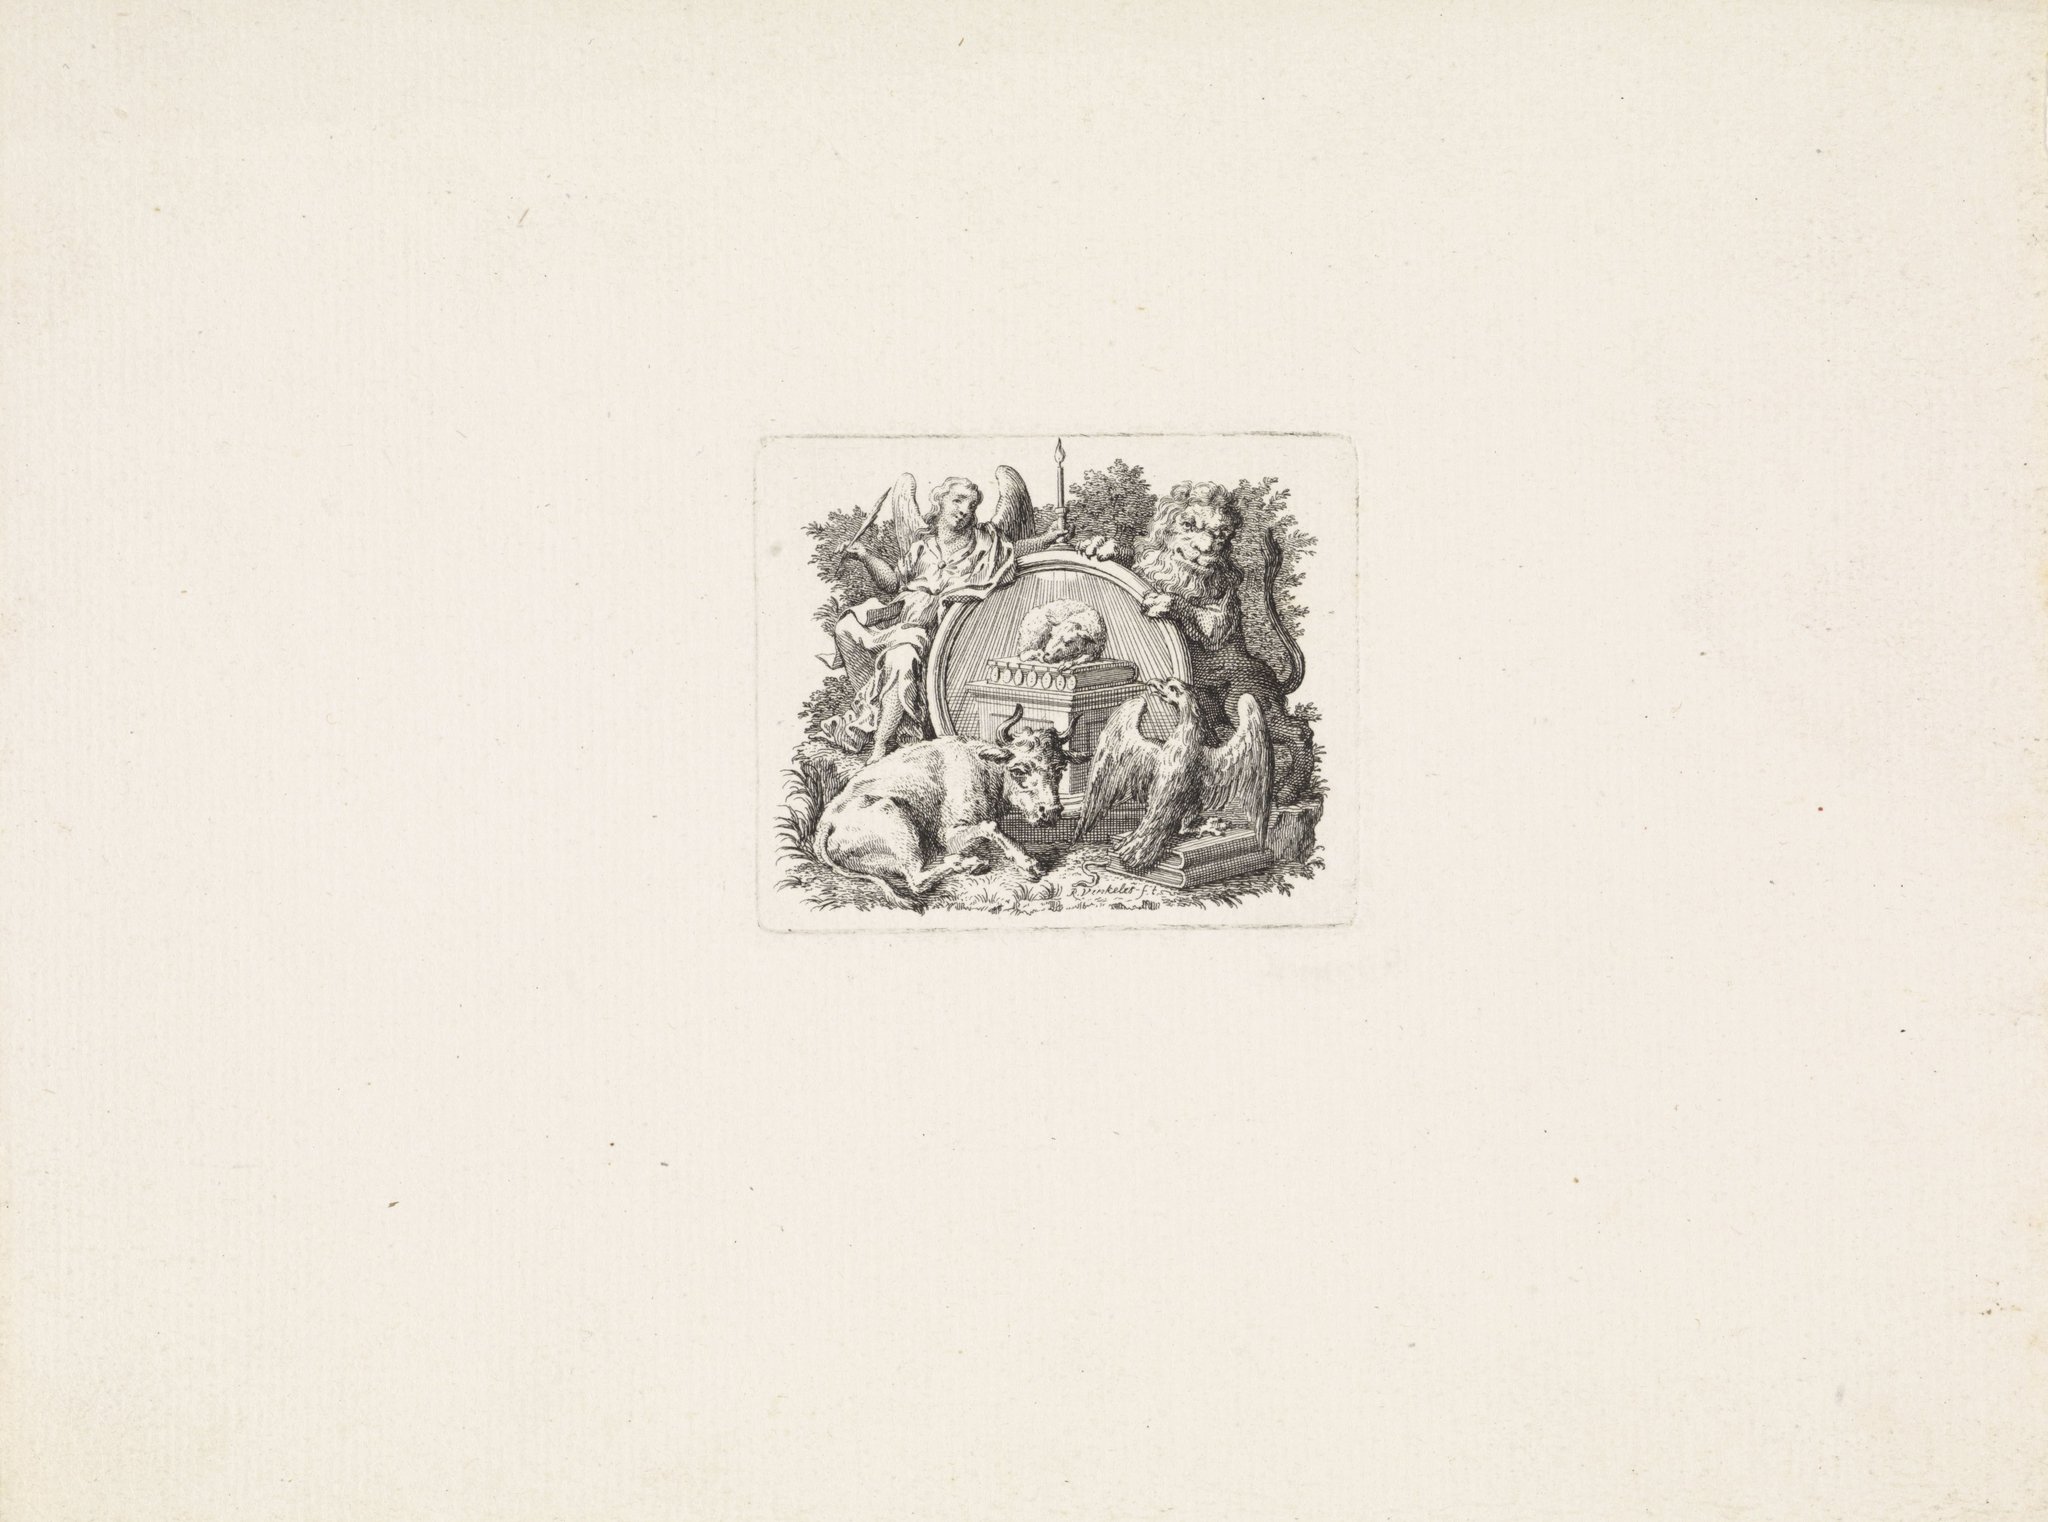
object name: print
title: Lam omringd door de evangelistensymbolen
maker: reinier vinkeles (i)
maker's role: draughtsman, print maker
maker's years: 1741-1816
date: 1751-1816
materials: paper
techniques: engraving, etching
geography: amsterdam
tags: the four symbols of the evangelists, 'the apocalyptic beasts', lamb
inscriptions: collector's mark: Lugt 240